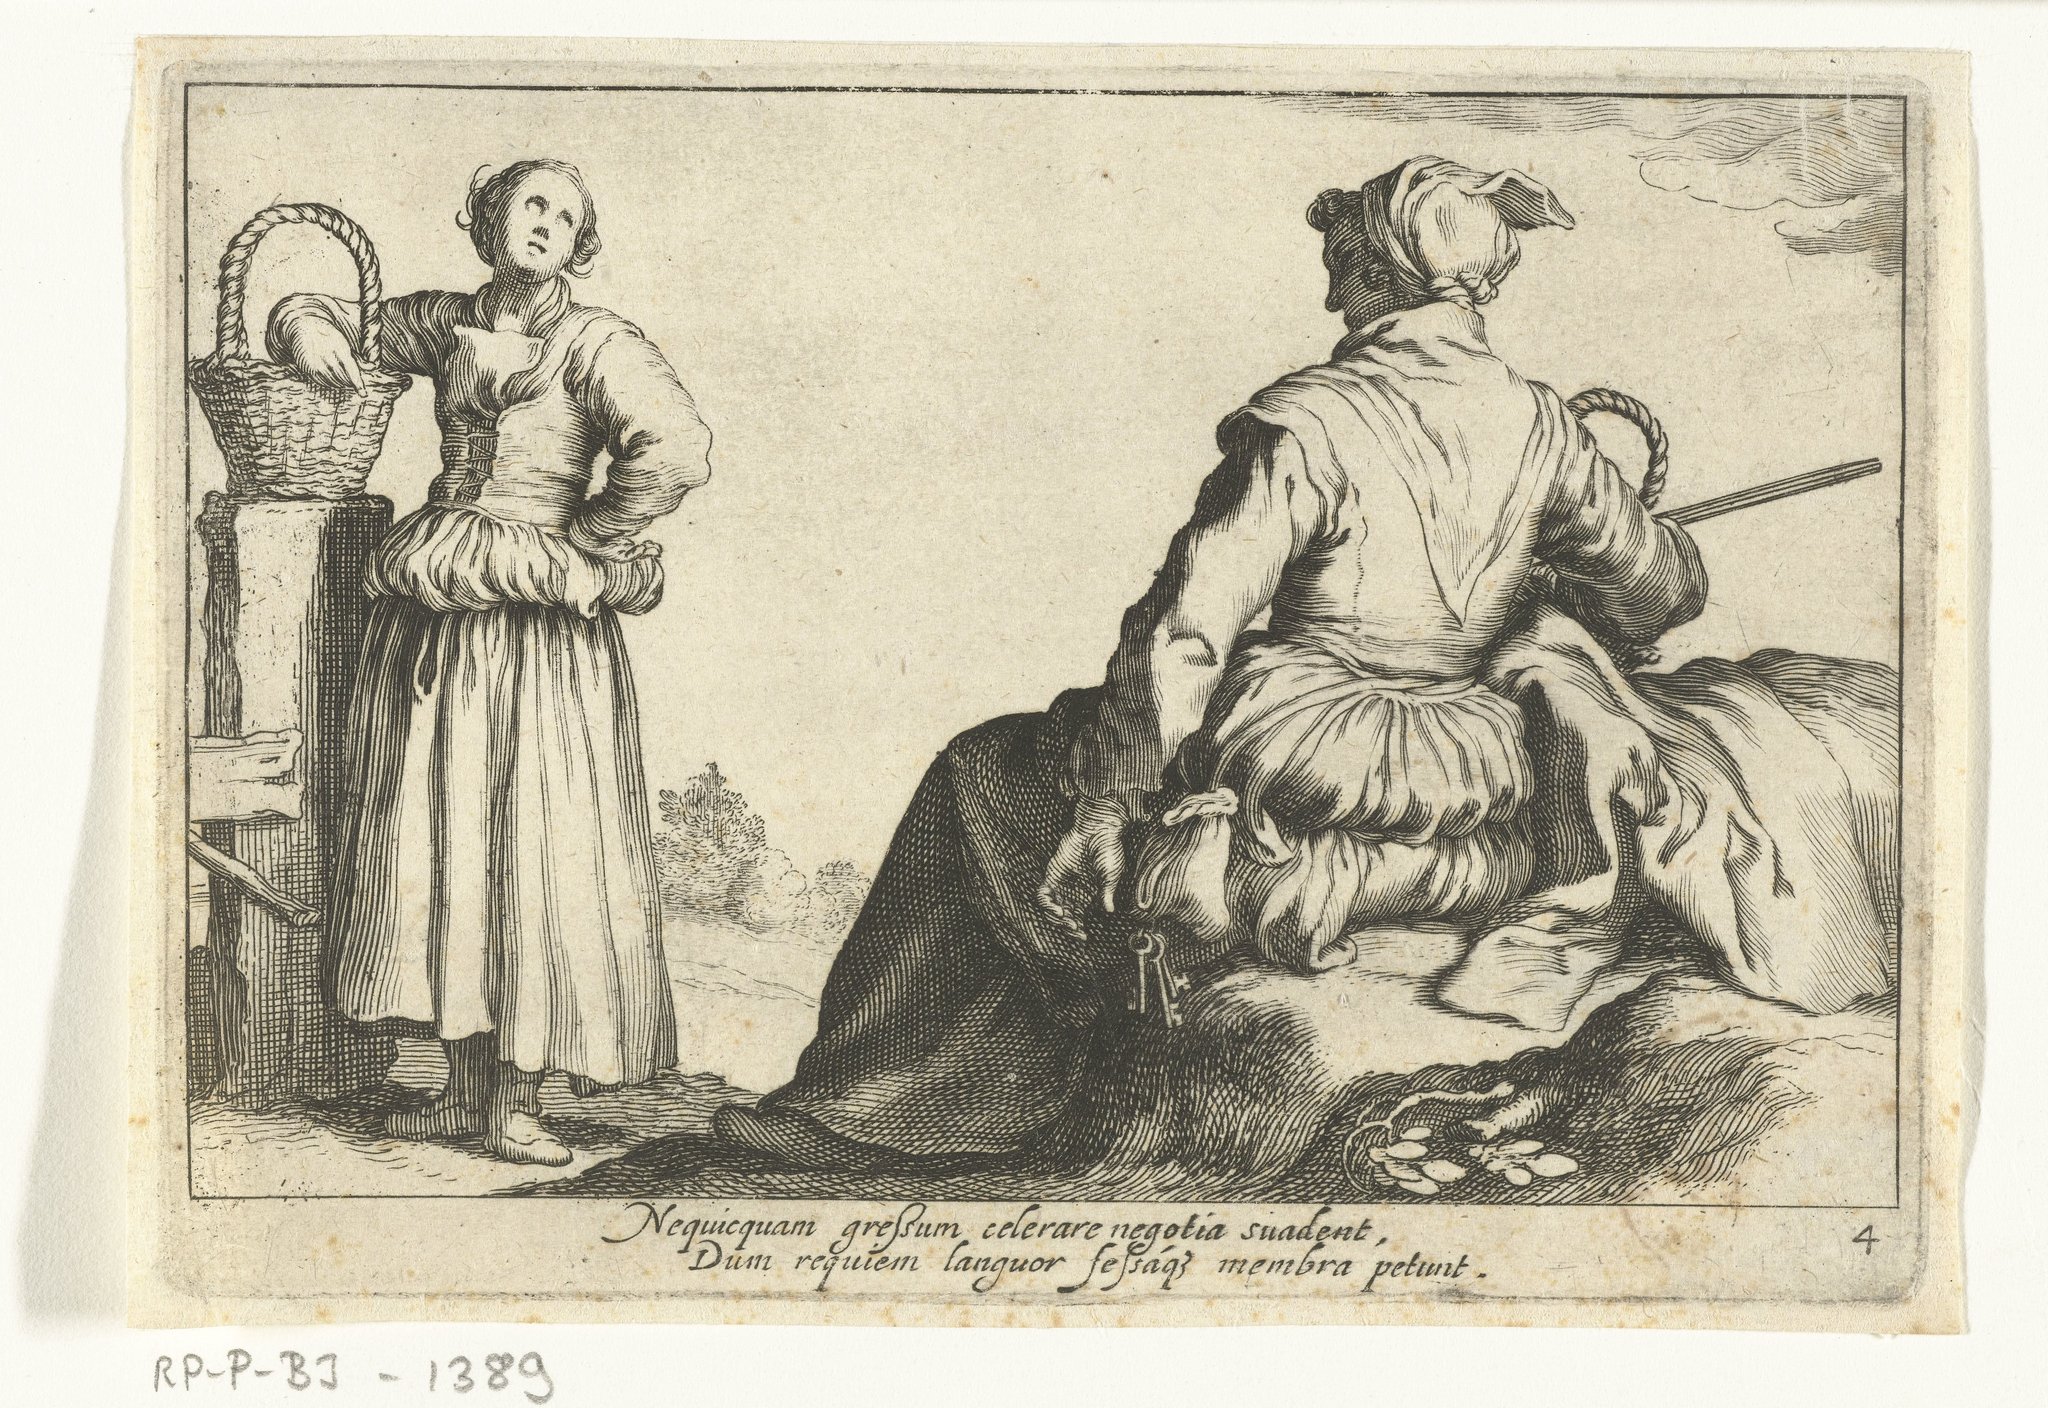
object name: print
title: Pastorale scènes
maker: cornelis bloemaert (ii)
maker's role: draughtsman, print maker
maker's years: 1603-1692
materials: paper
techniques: engraving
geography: utrecht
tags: pastorals, arcadian scenes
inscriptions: collector's mark: Lugt 240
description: Twee vrouwen met manden rusten uit. Met tweeregelig Latijns onderschrift.